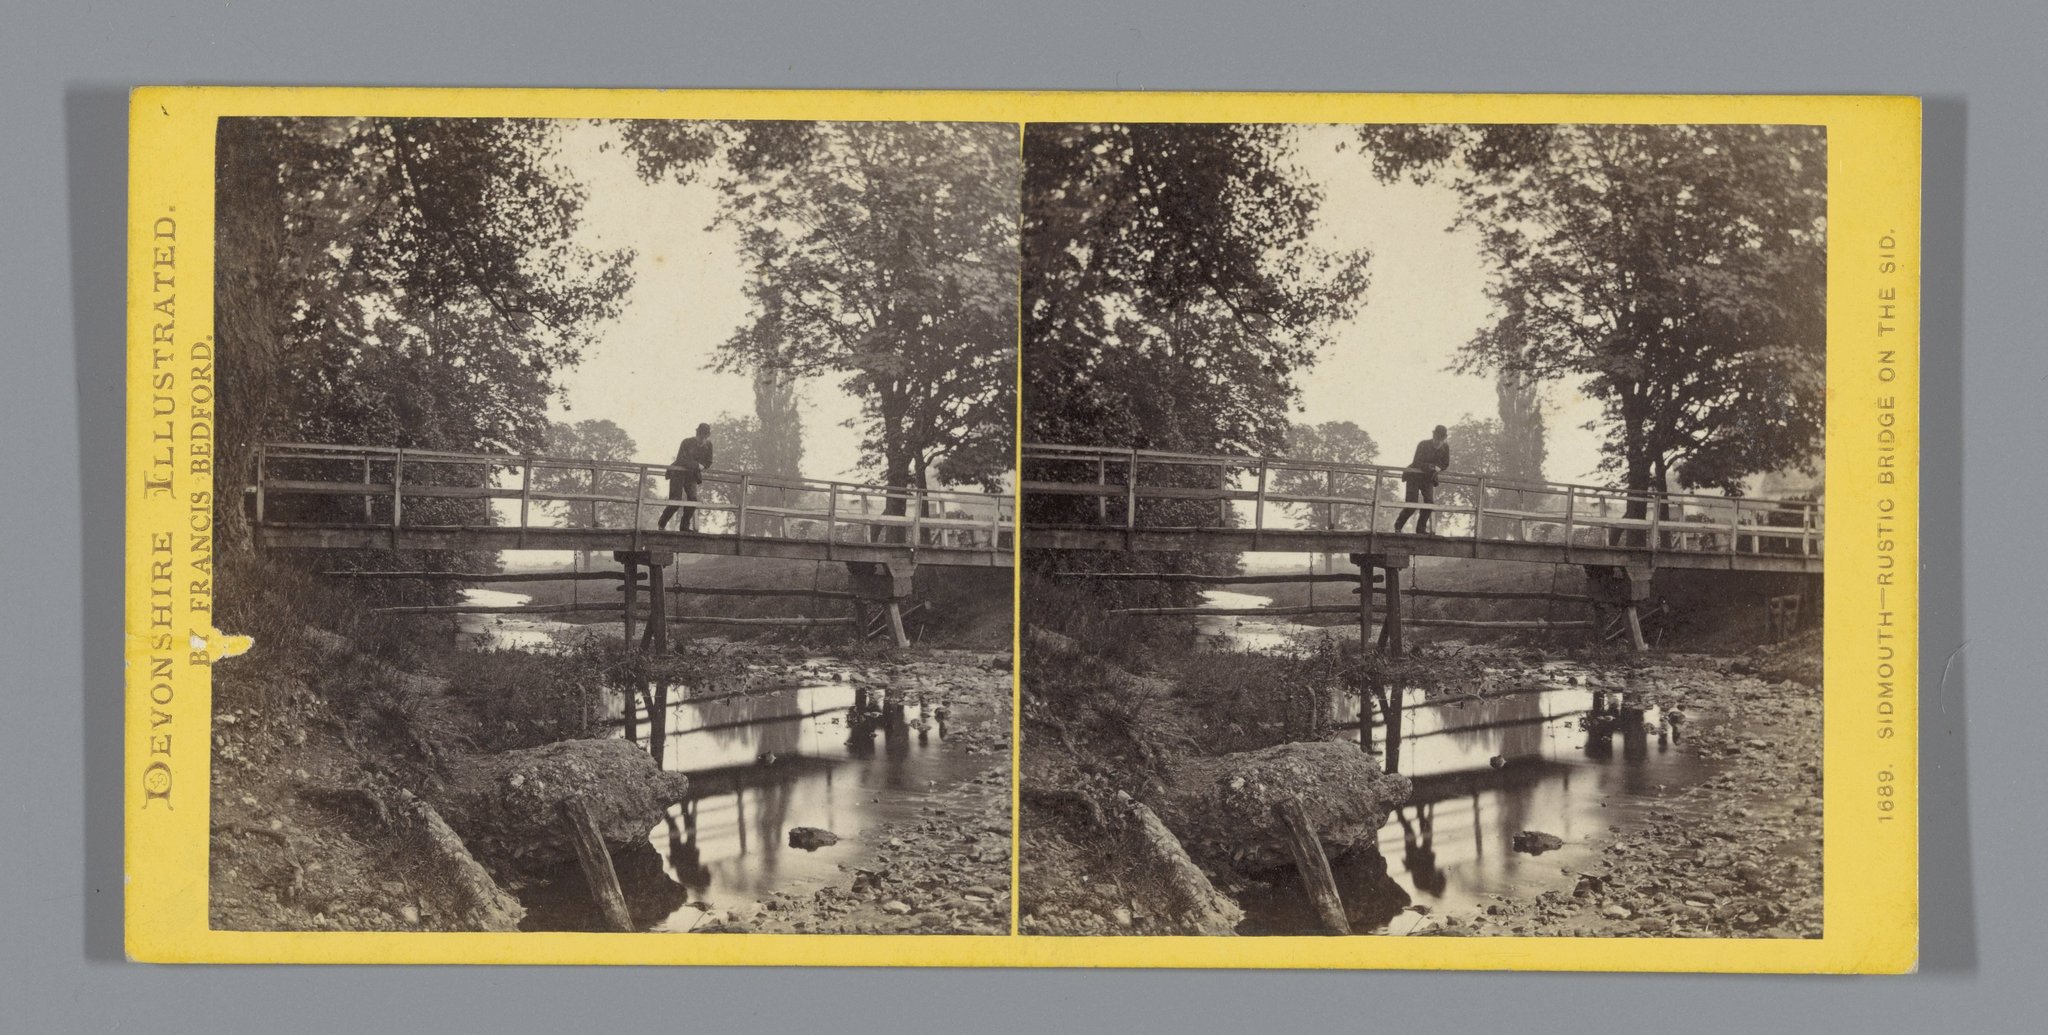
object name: stereograph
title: Sidmouth-Rustic bridge on the Sid.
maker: francis bedford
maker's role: print maker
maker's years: 1815-1894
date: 1850-1880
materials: cardboard, photographic support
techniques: albumen print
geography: sidmouth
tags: river, landscape with bridge, viaduct or aqueduct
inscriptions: inscription: ‘F.T.’, number: ‘1689.’, inscription: ‘Devonshire Illustrated. by Francis Bedford.’